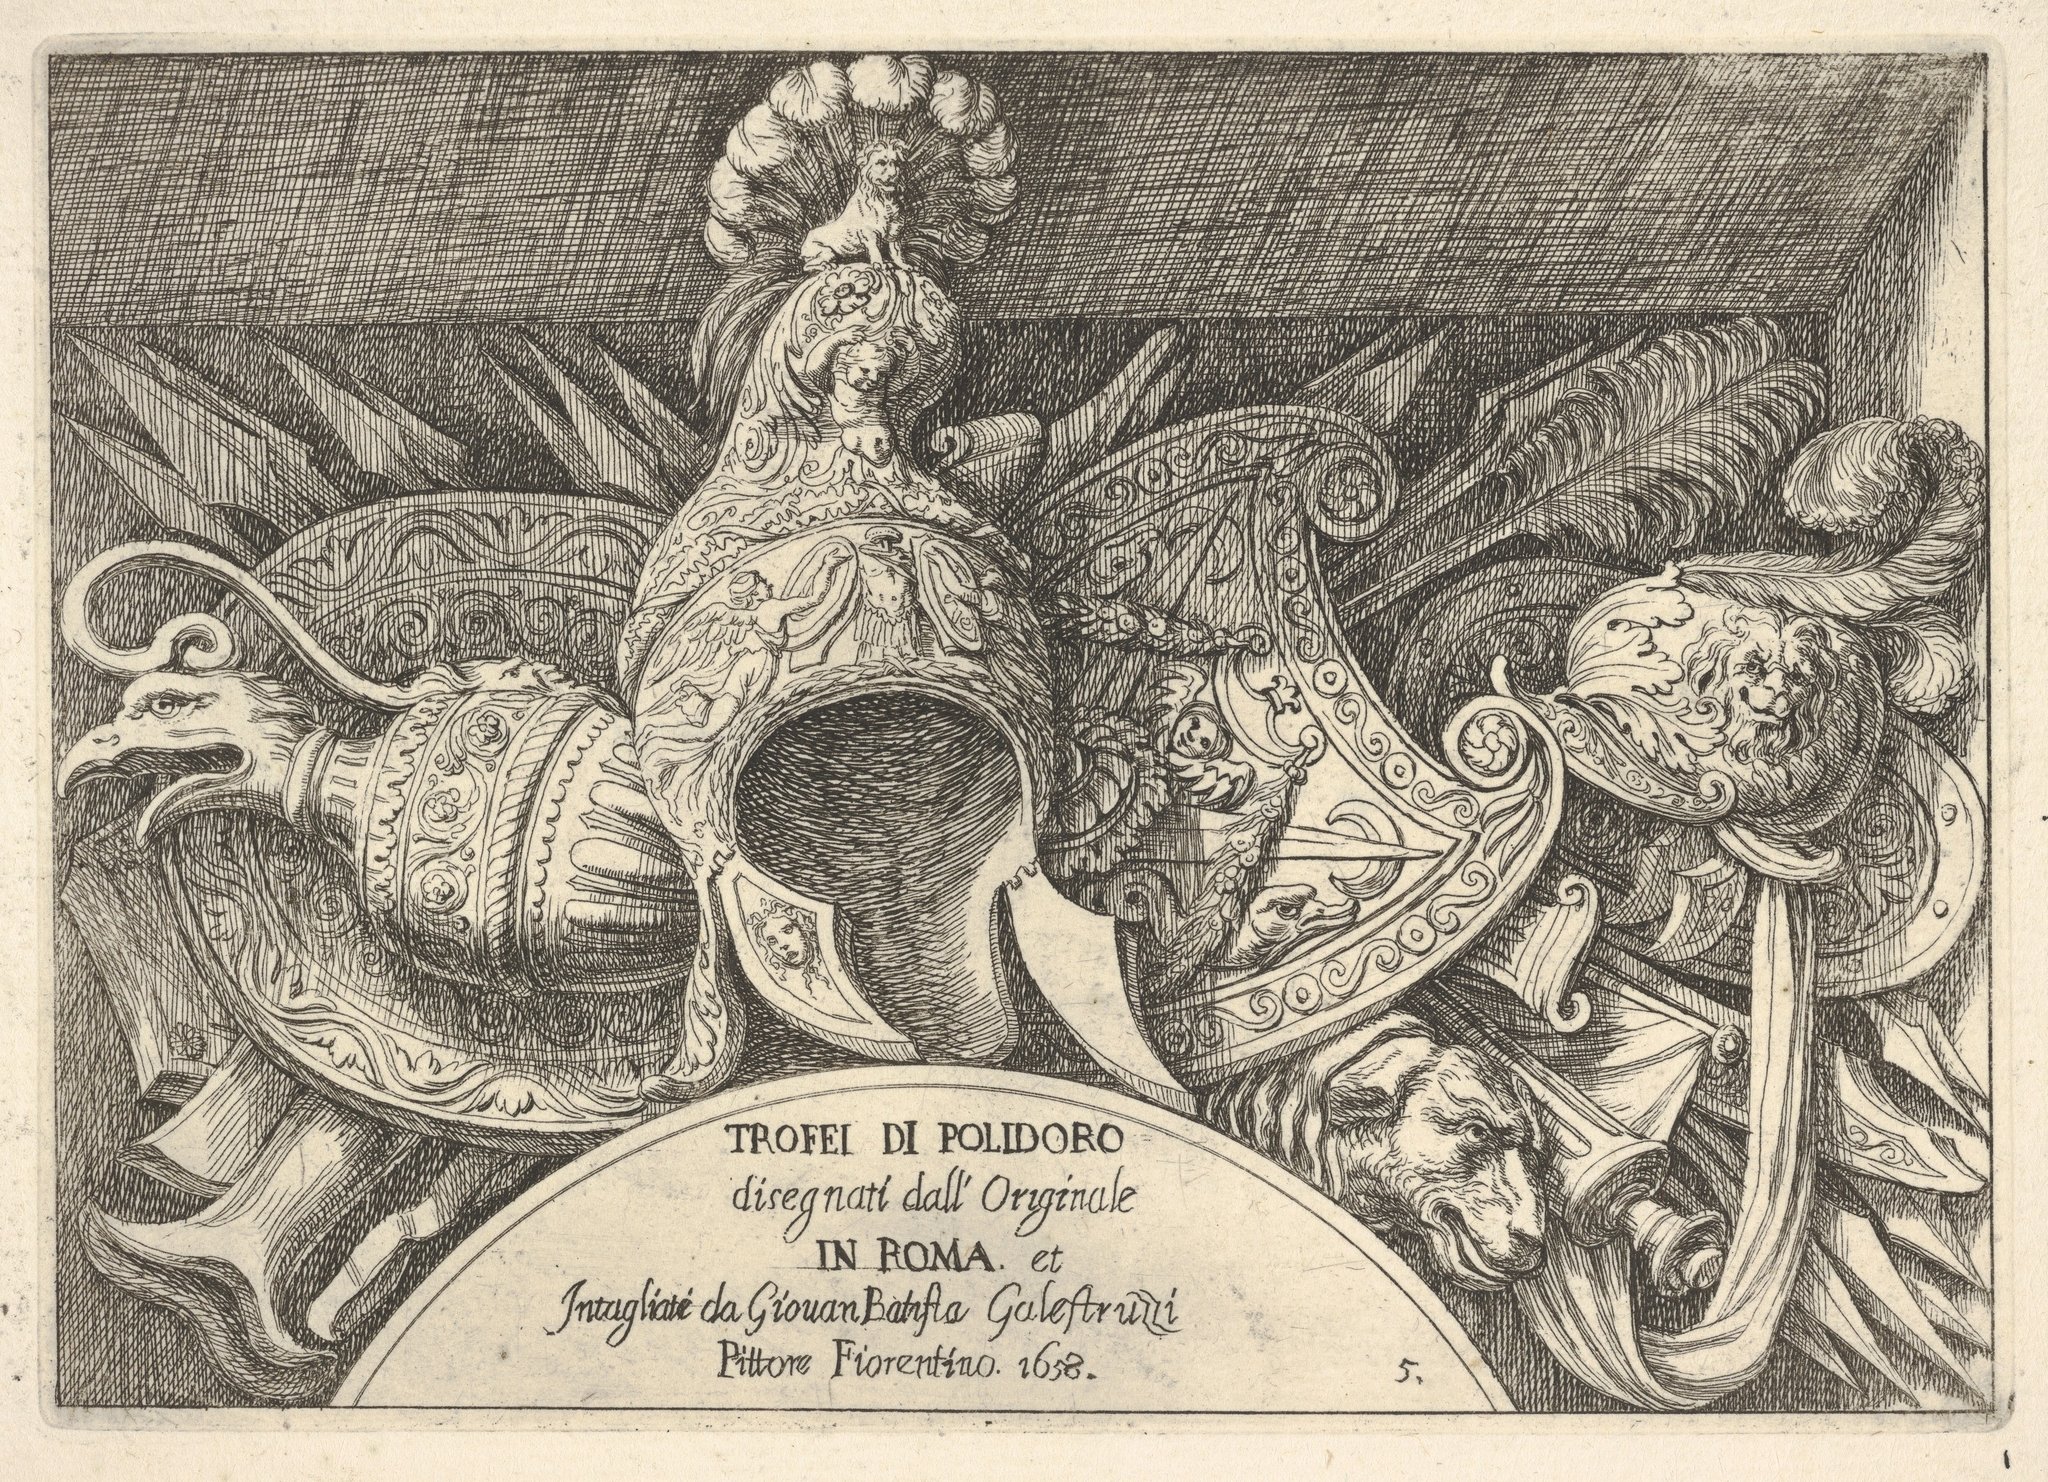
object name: print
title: Plate 5: trophies of Roman arms from decorations above the windows on the second floor of the Palazzo Milesi in Rome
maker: giovanni battista galestruzzi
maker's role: artist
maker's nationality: italian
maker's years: 1615-1669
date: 1658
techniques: etching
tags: animals,birds,helmets,trophies